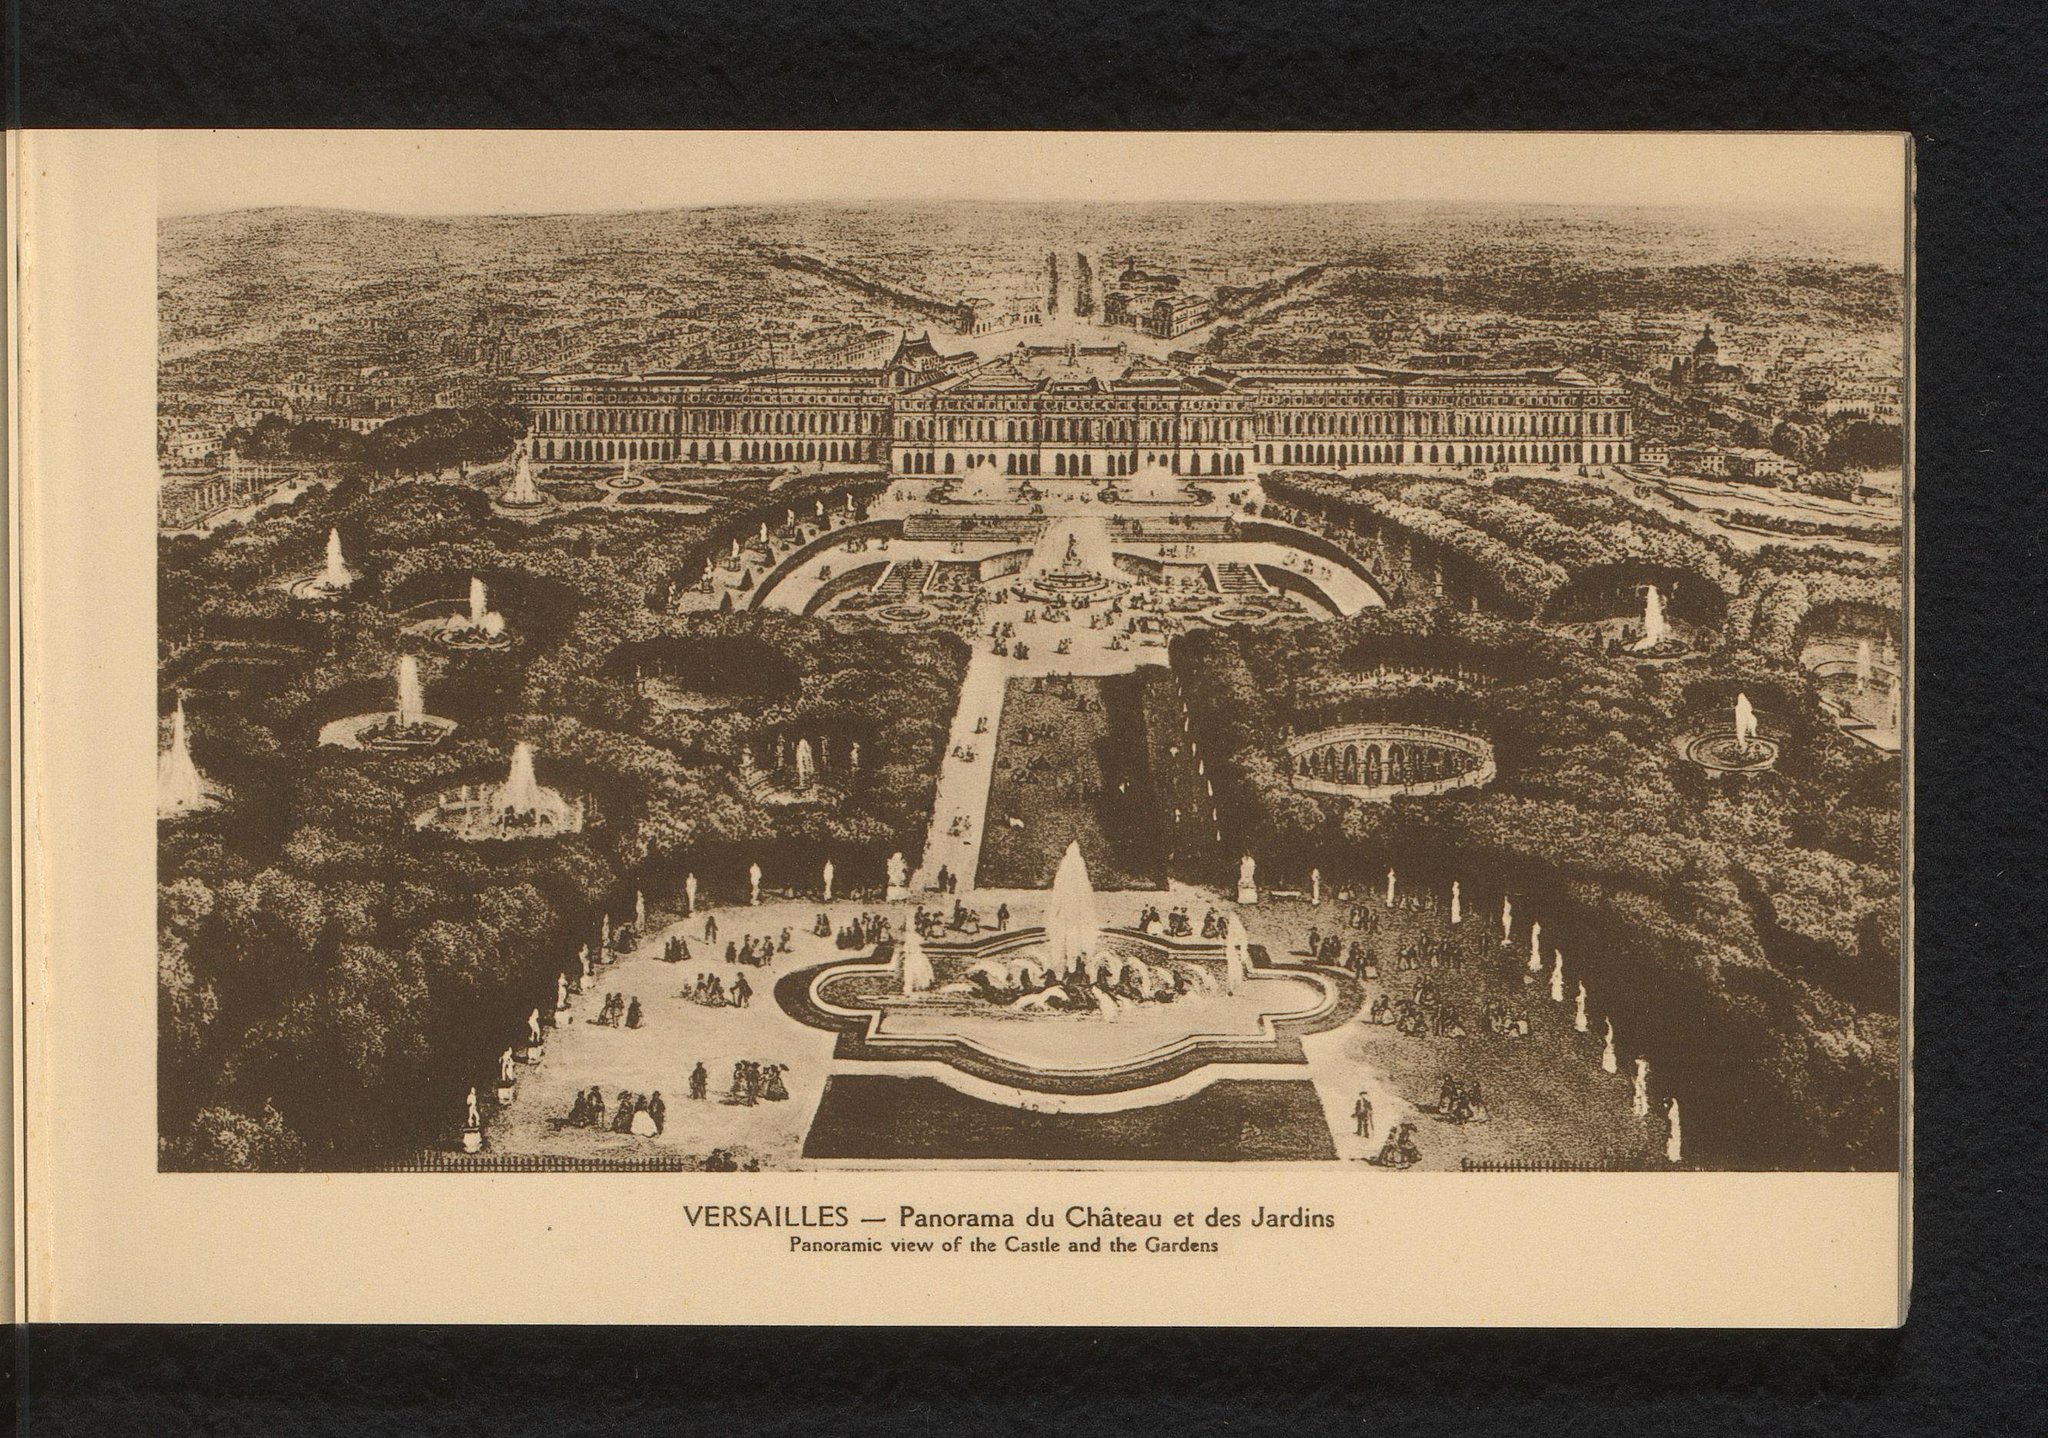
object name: reproduction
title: Versailles. Panorama du Château et des Jardins / Panoramic view of the Castle and the Gardens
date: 1919-1930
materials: cardboard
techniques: photograph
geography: paris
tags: palace, french or architectonic garden; formal garden